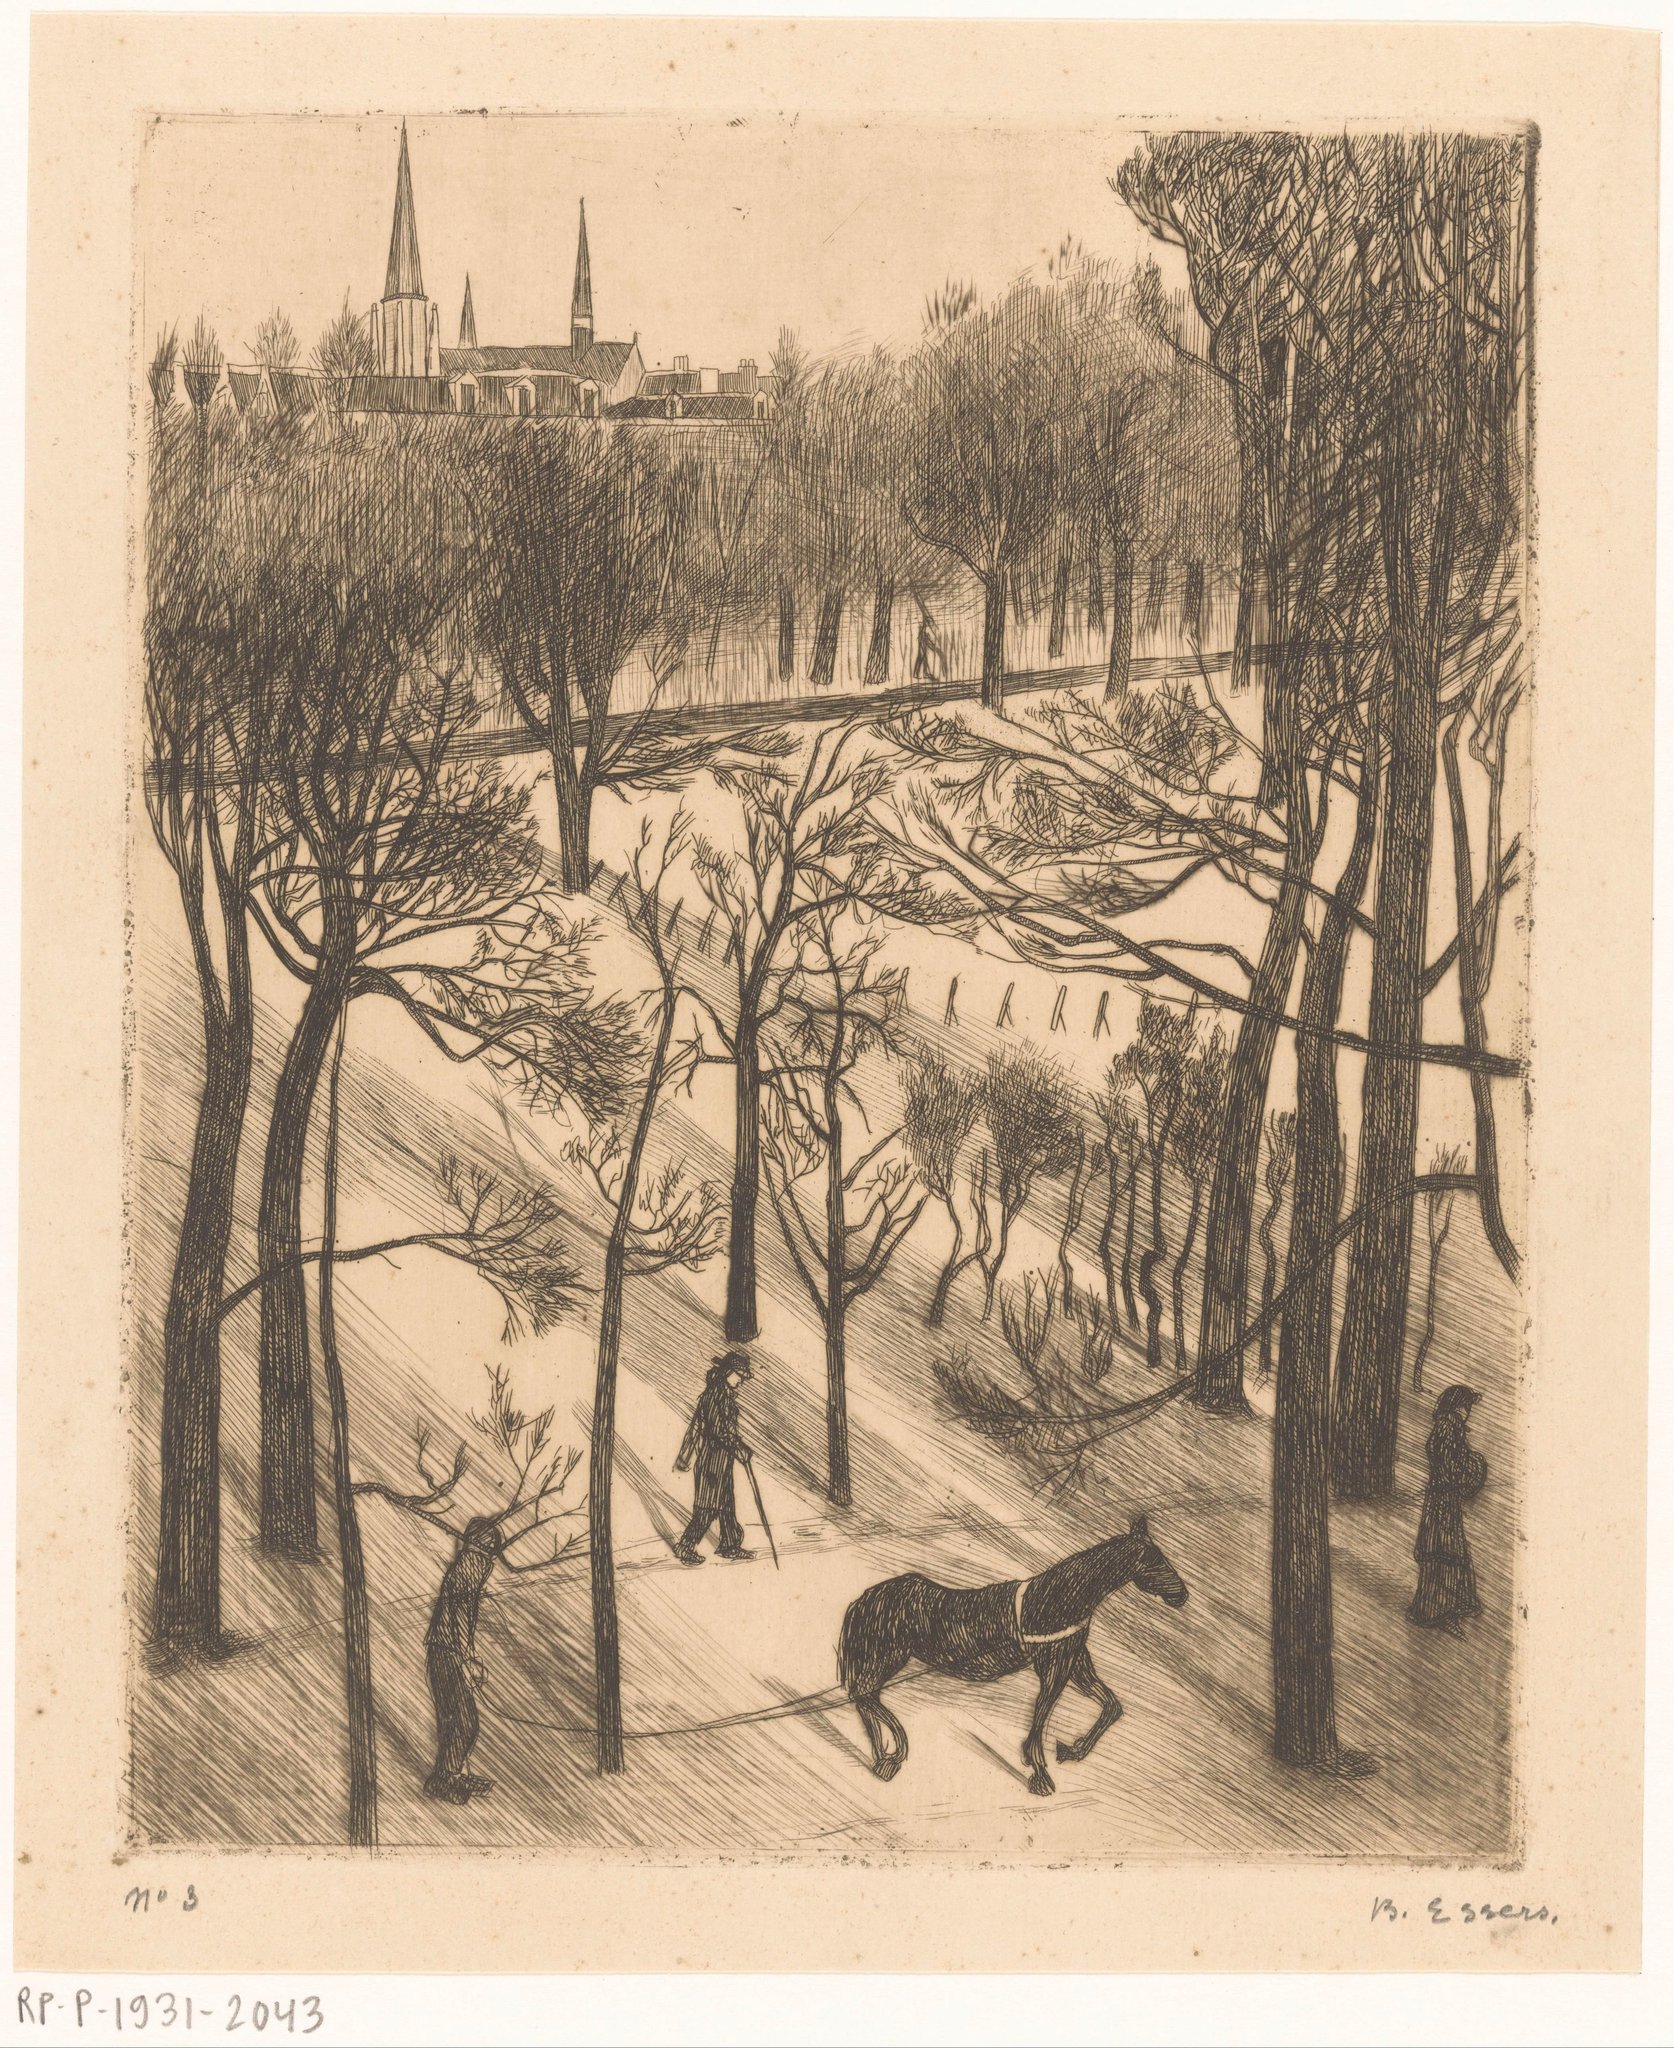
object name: print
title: Vondelpark in de winter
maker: bernard essers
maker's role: print maker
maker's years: 1893-1945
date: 1914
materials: paper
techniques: etching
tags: park, horse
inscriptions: collector's mark: Lugt 2228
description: Twee wandelende figuren en een figuur met een paard in een park met kale bomen. Links op de achtergrond een kerk te midden van huizen.